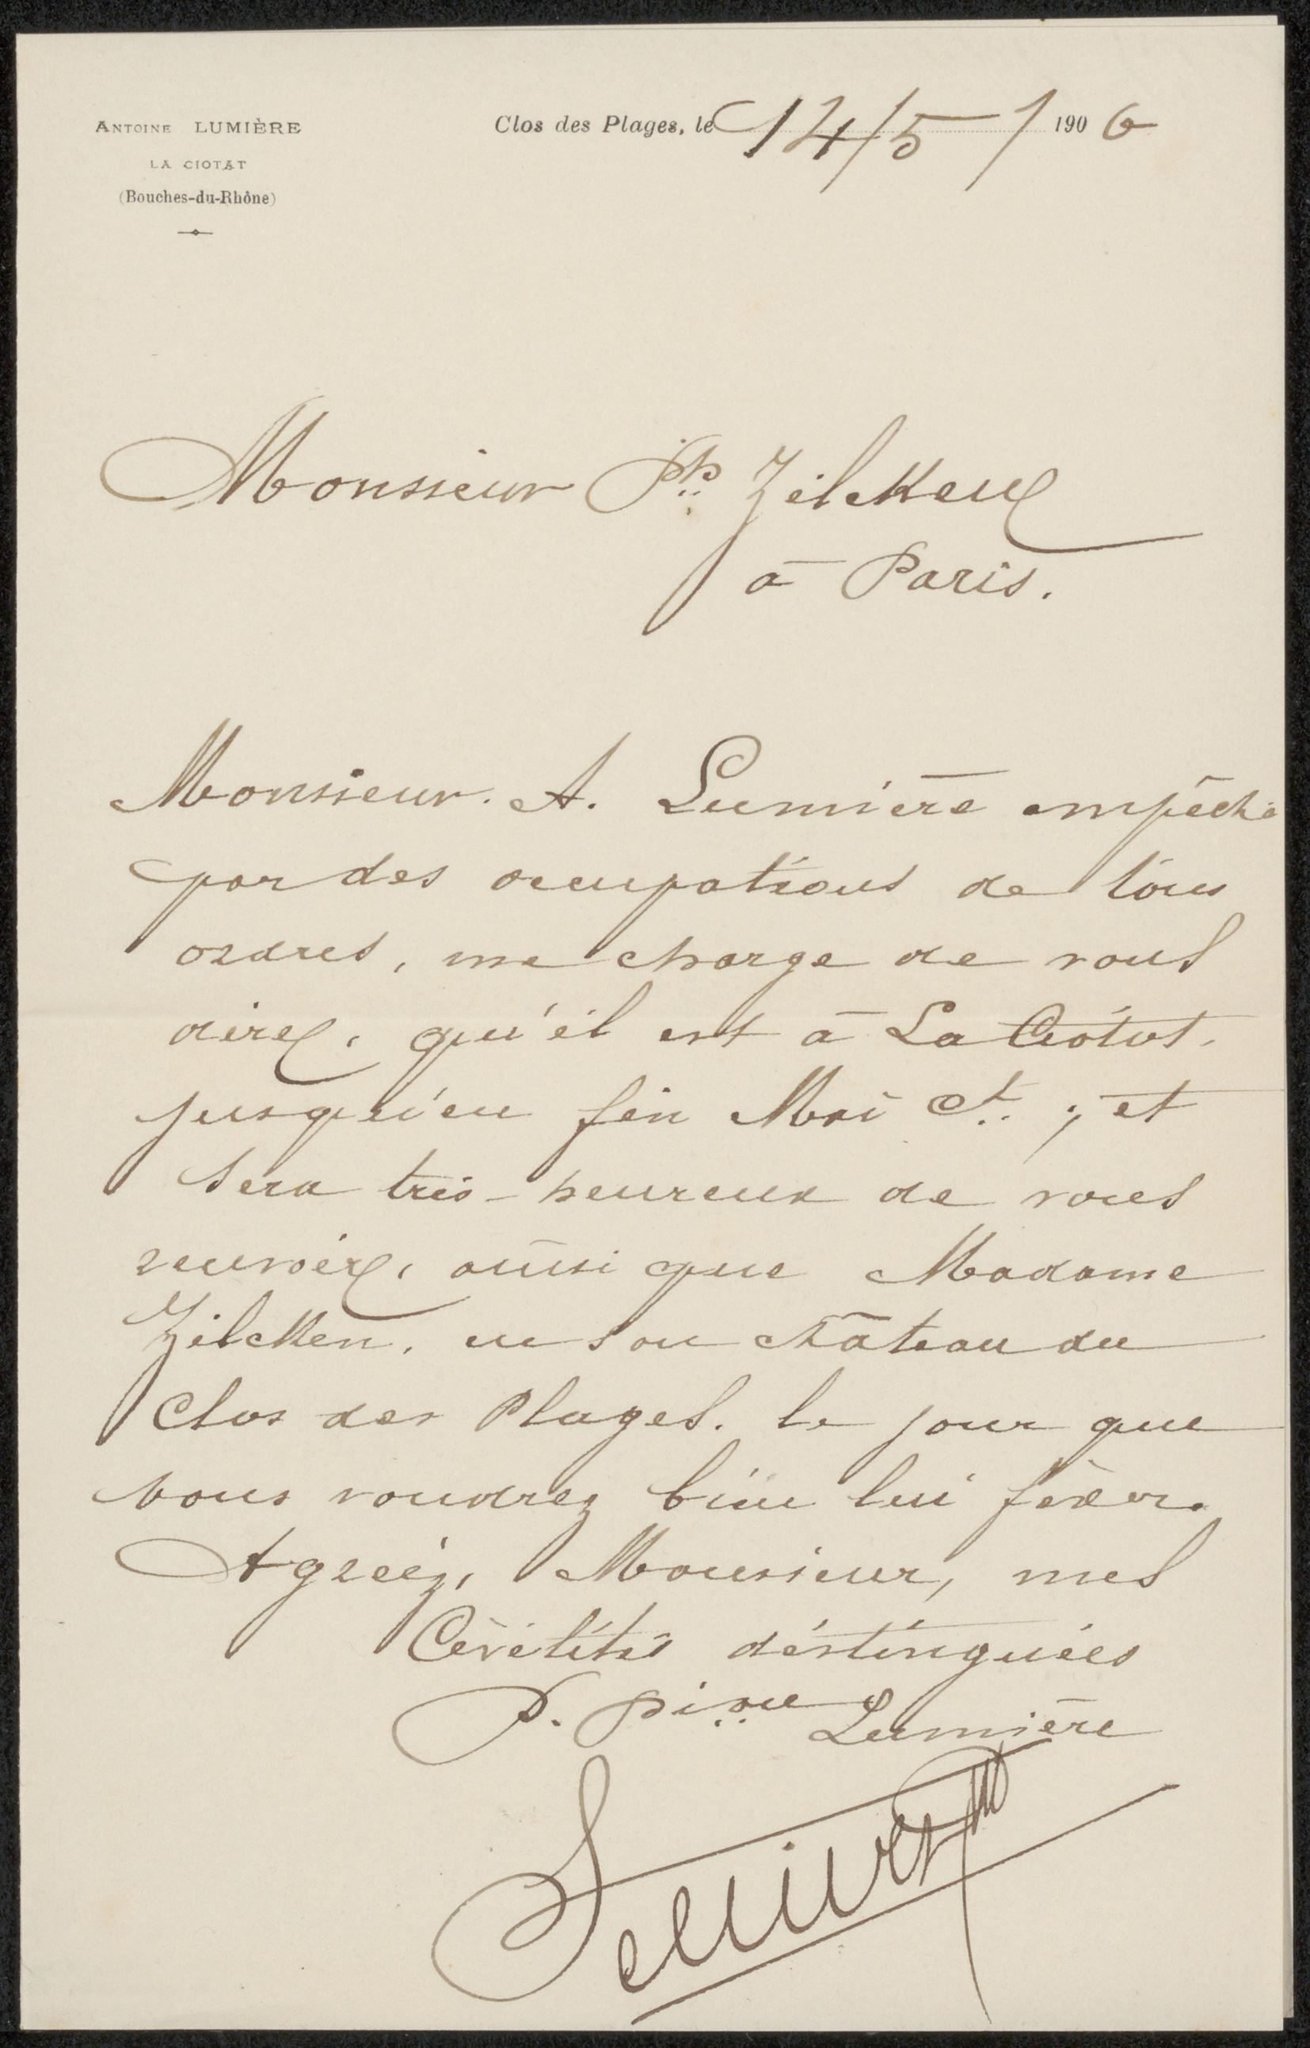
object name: letter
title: Brief aan Philip Zilcken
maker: félix fénéon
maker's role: handelaar, kunstcriticus, verzamelaar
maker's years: 1861-1944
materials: ink, paper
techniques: pen, writing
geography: paris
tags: antoine lumière, the hague, draughtsman, philip zilcken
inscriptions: collector's mark: ‘RPK’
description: Bevat een brief van Antoine Lumière aan Philip Zilcken, gedateerd 14 mei 1906.